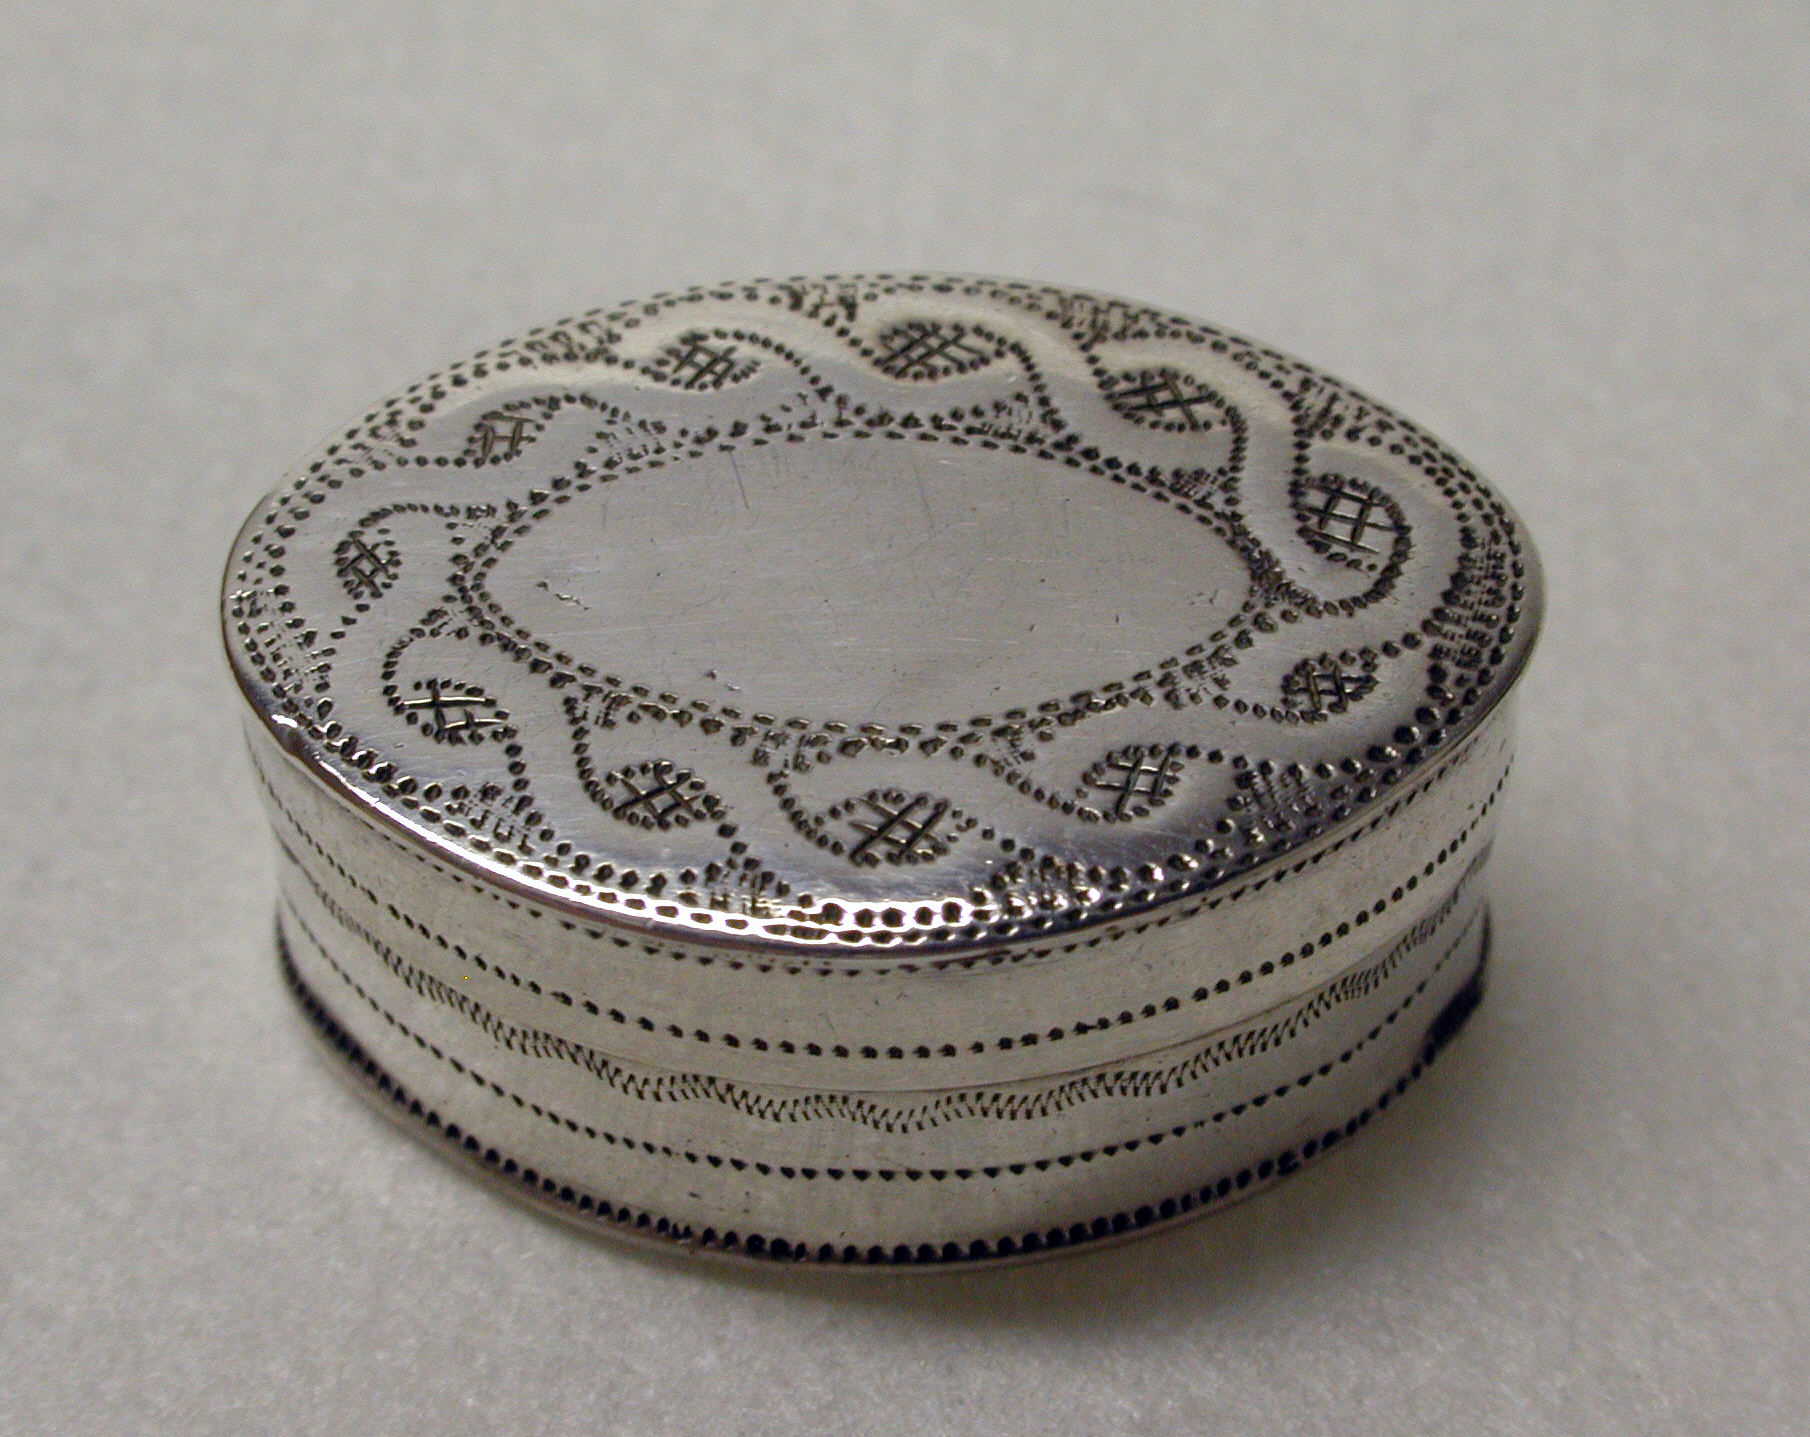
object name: vinaigrette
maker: samuel pemberton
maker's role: maker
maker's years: 1750-1850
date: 1800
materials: silver